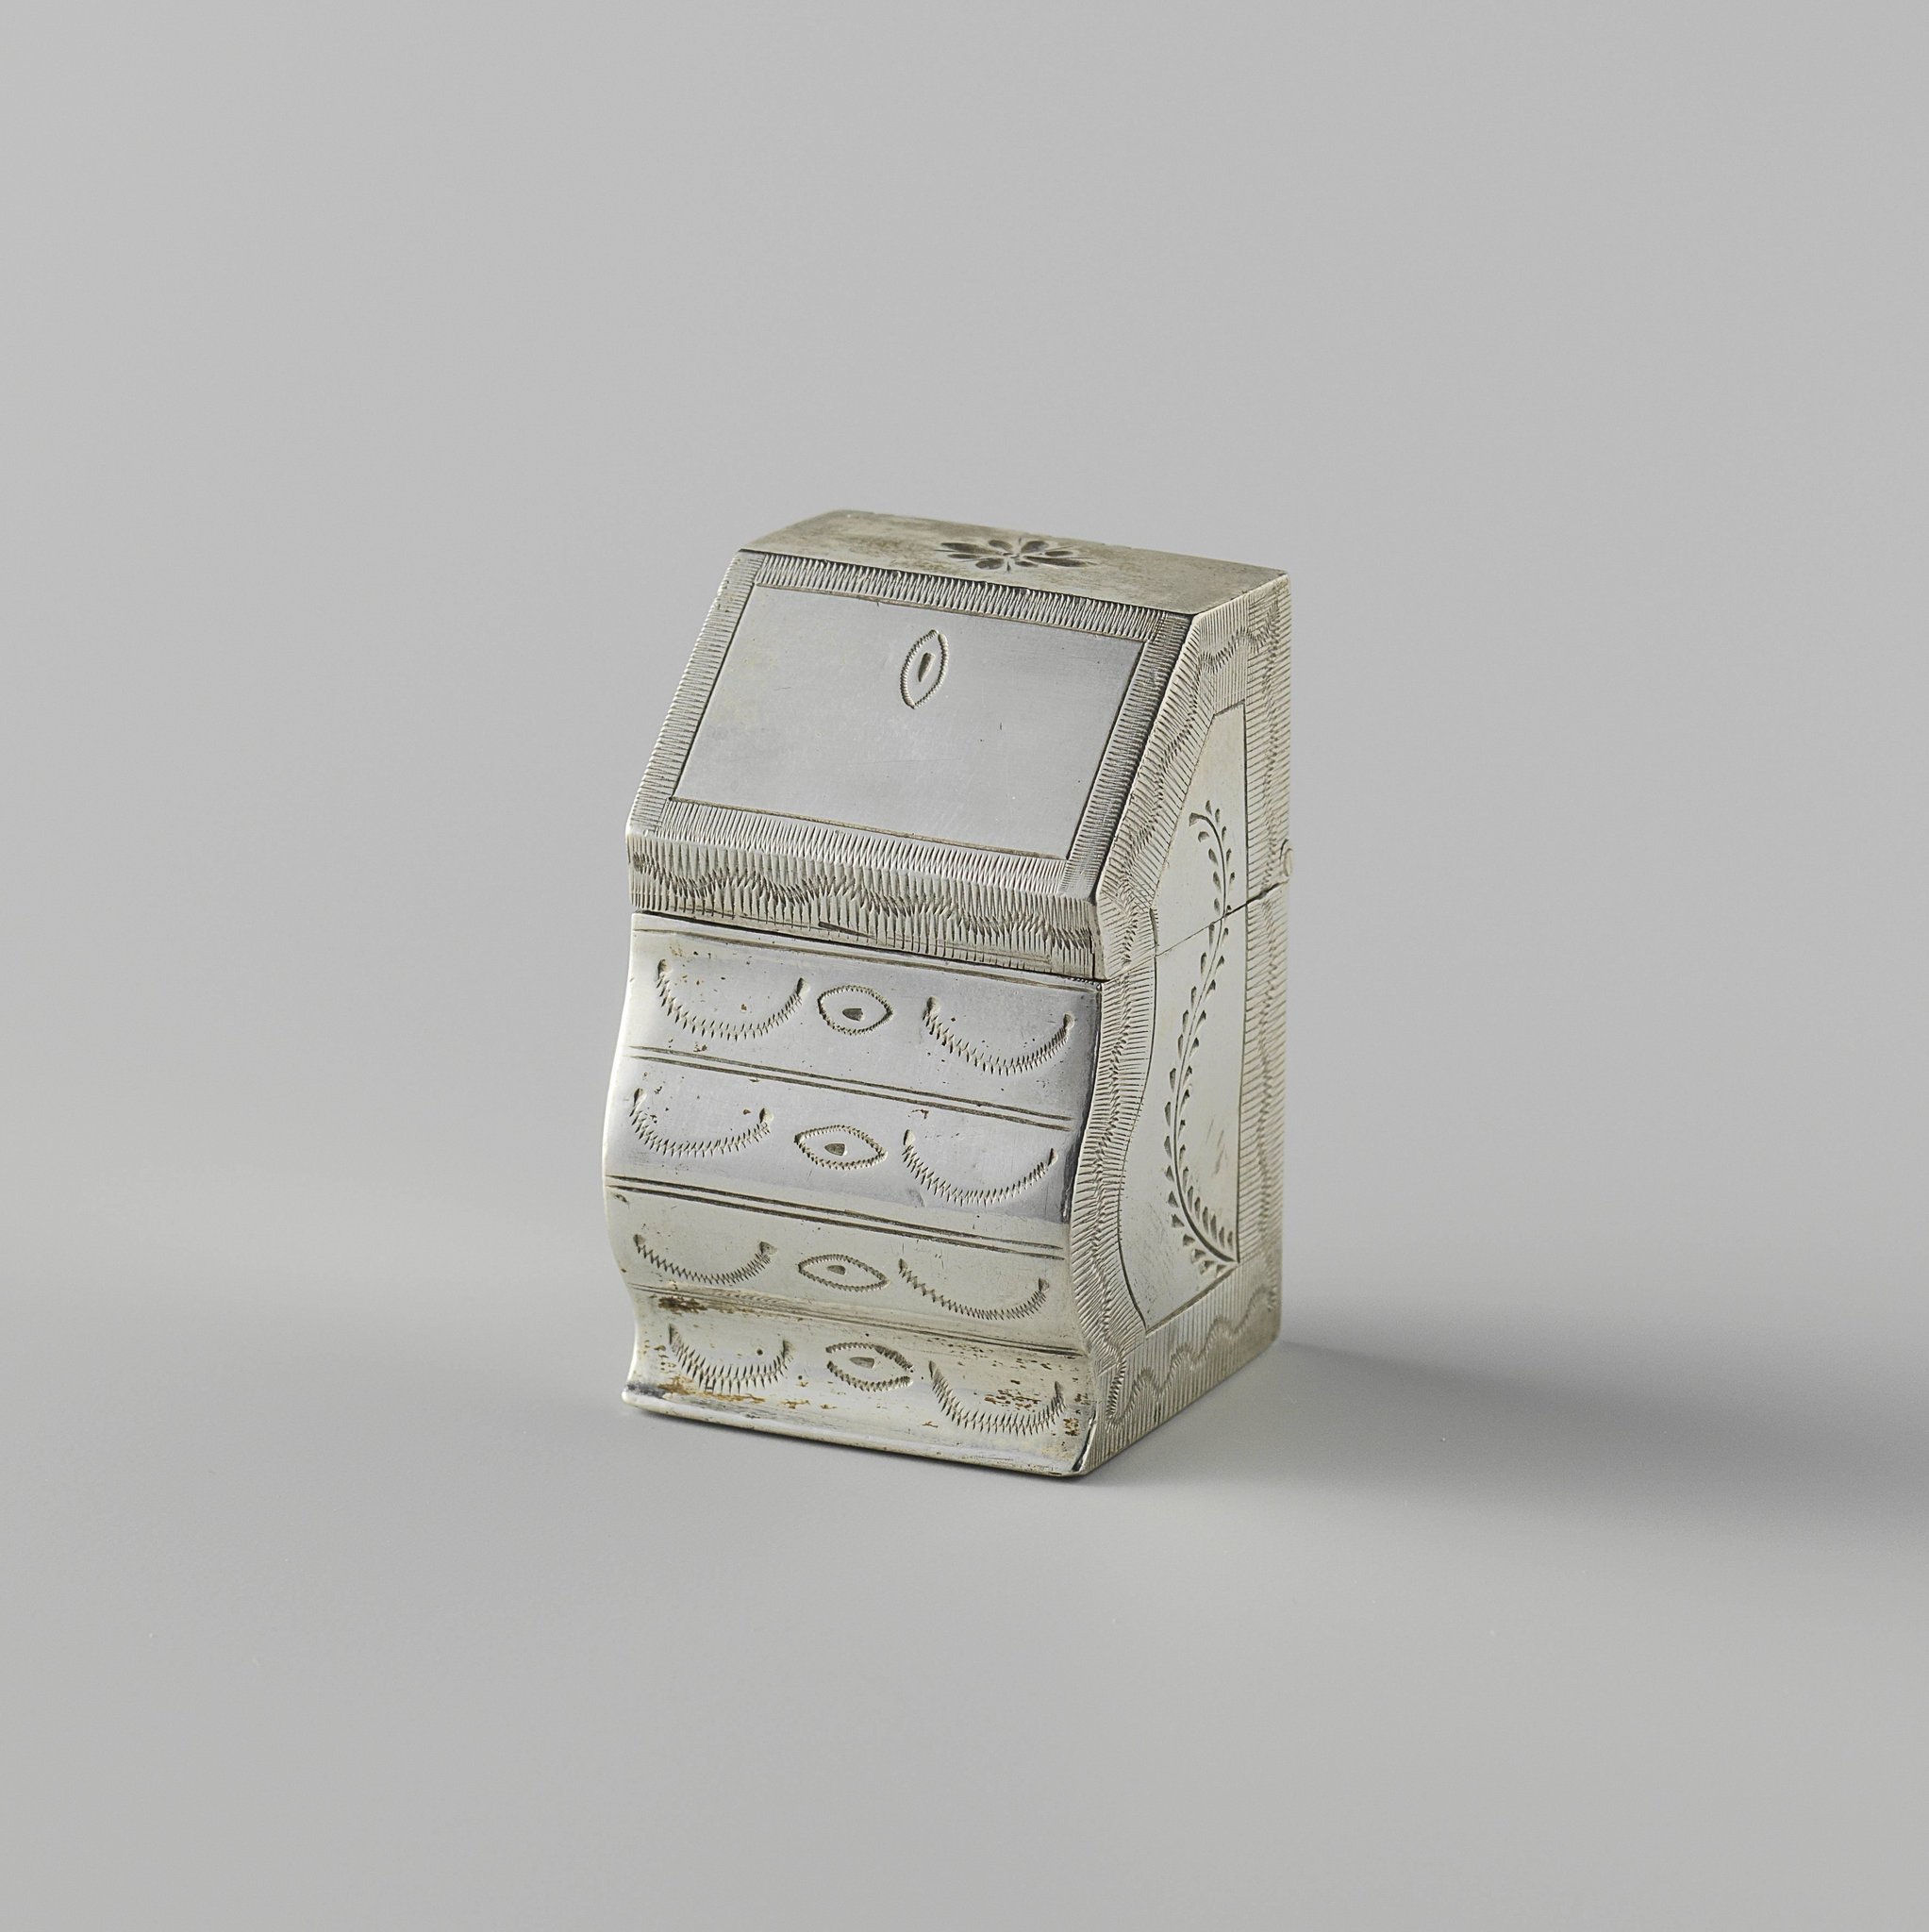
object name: miniature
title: Koffietrommel in de vorm van een secretaire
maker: adrianus kuylenburg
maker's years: 1760-1831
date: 1784-1798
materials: silver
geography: schoonhoven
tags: writing-table, writing-desk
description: Koffietrommel van zilver in de vorm van een secretaire.